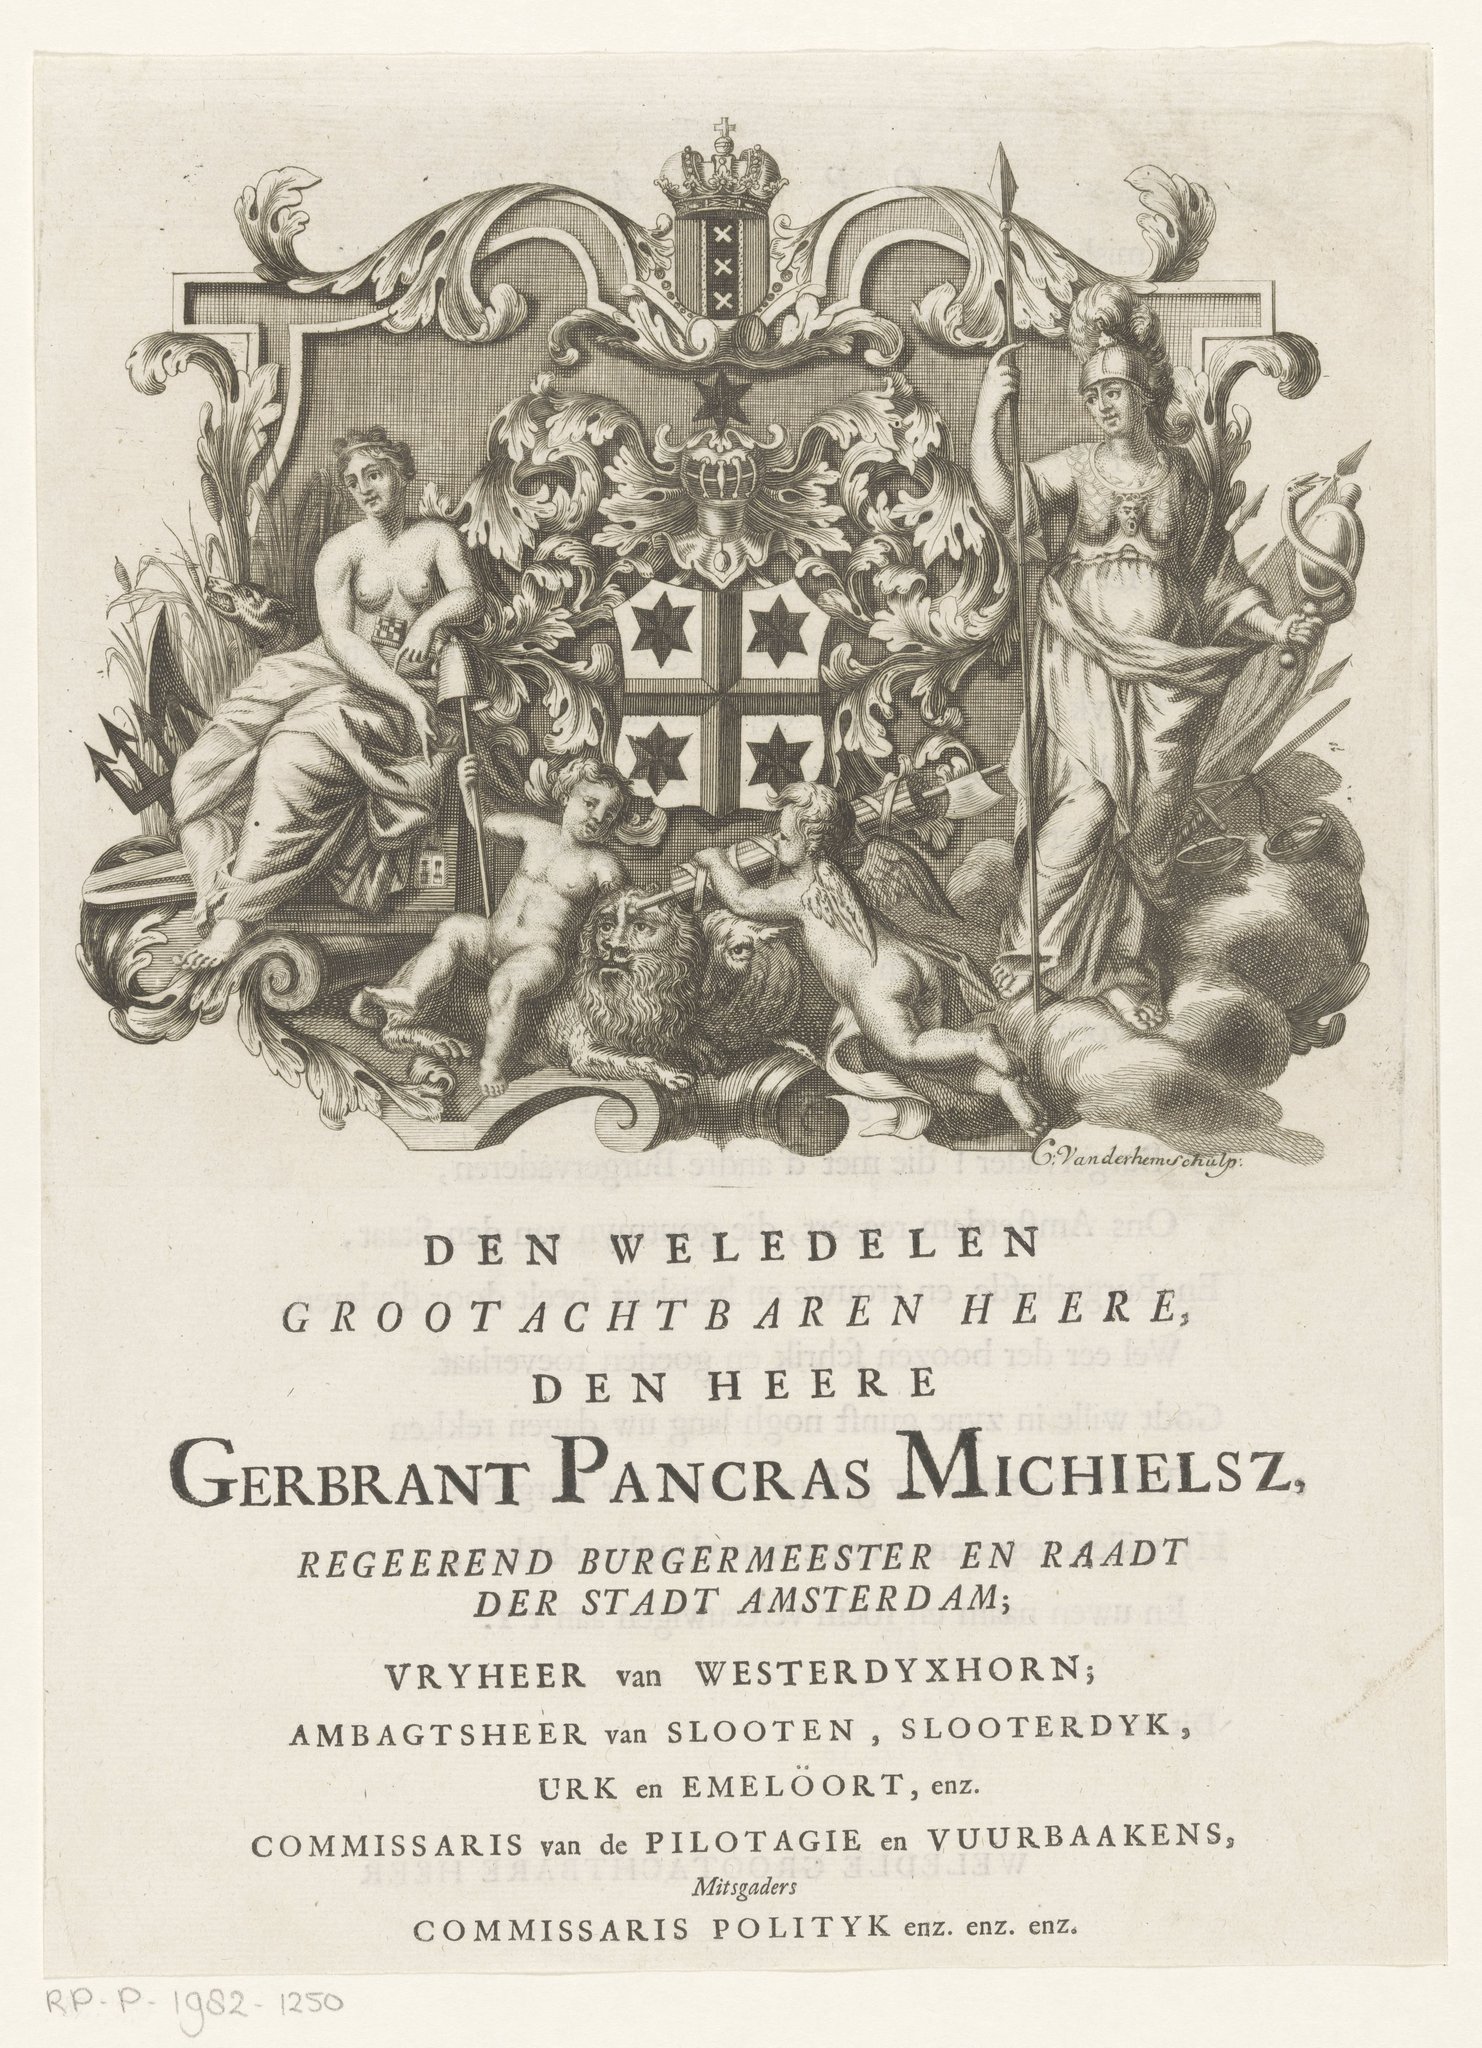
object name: print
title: Wapen van Gerbrand Pancras Michielsz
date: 1722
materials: paper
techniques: engraving, etching, letterpress printing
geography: amsterdam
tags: specific aspects, allegorical aspects of minerva; minerva as patroness, beasts of prey, predatory animals: lion, cupids: 'amores', 'amoretti', 'putti', armorial bearing, heraldry, amsterdam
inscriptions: collector's mark: Lugt 2228, collector's mark: Lugt 2760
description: Een familiewapen met vier sterren geflankeerd door Minerva en een zittend vrouwelijk halfnaakt. Onderaan twee putti bij een liggende leeuw. Bovenaan het wapen van Amsterdam met een kroon. Aan de onderzijde en verso de opdracht aan Gerbrant Pancras Michielsz.